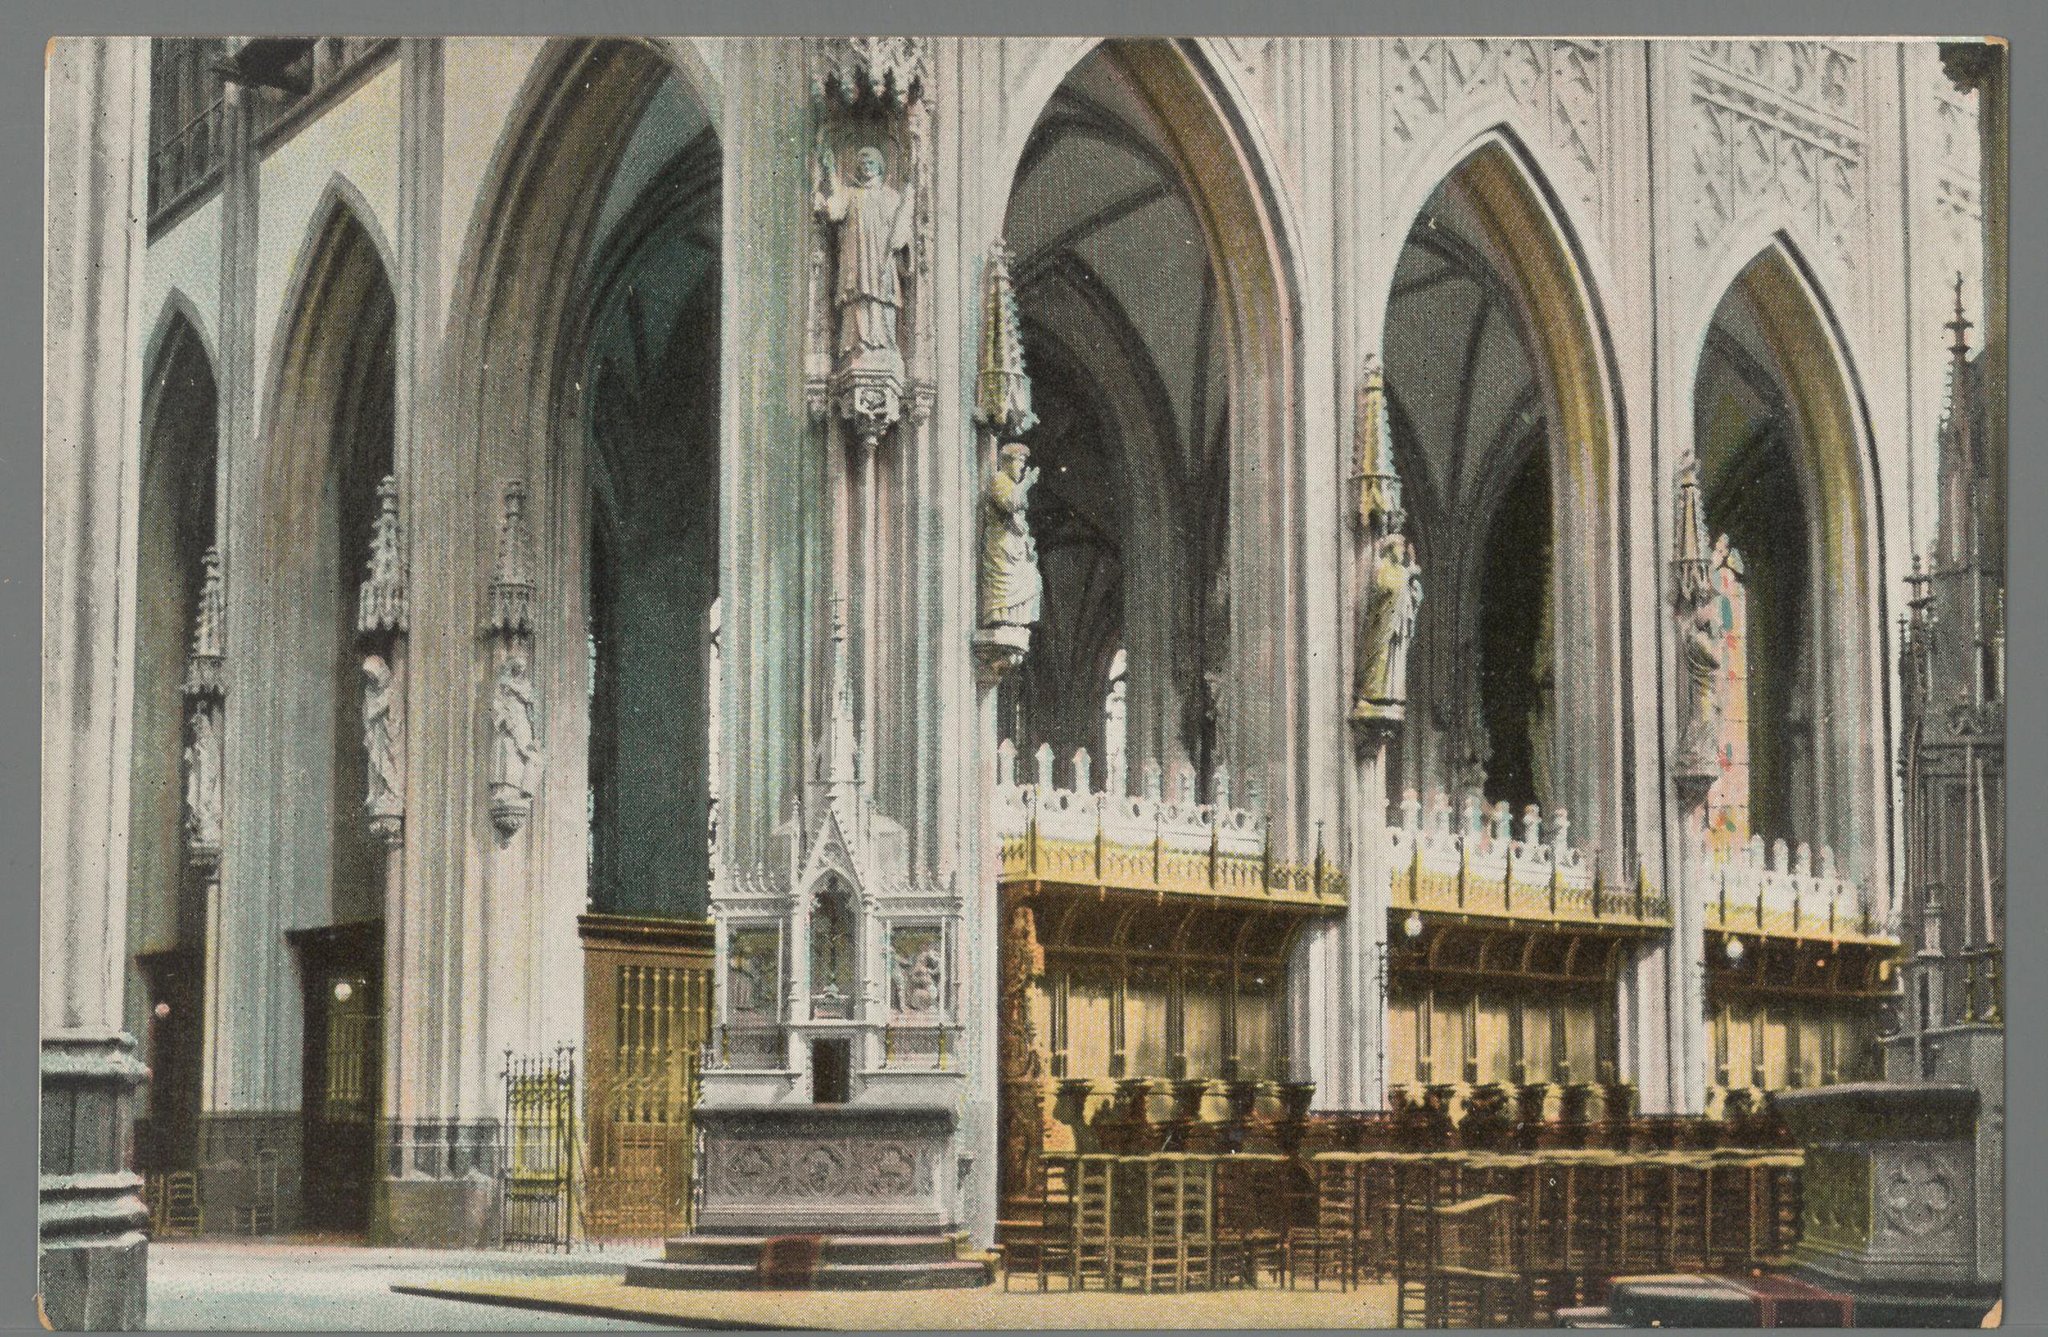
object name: photomechanical print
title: Noordertransept en choor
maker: Anonymous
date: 1905-1919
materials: cardboard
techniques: lithograph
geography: haarlem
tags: parts of church interior: transept, parts of church interior: choir